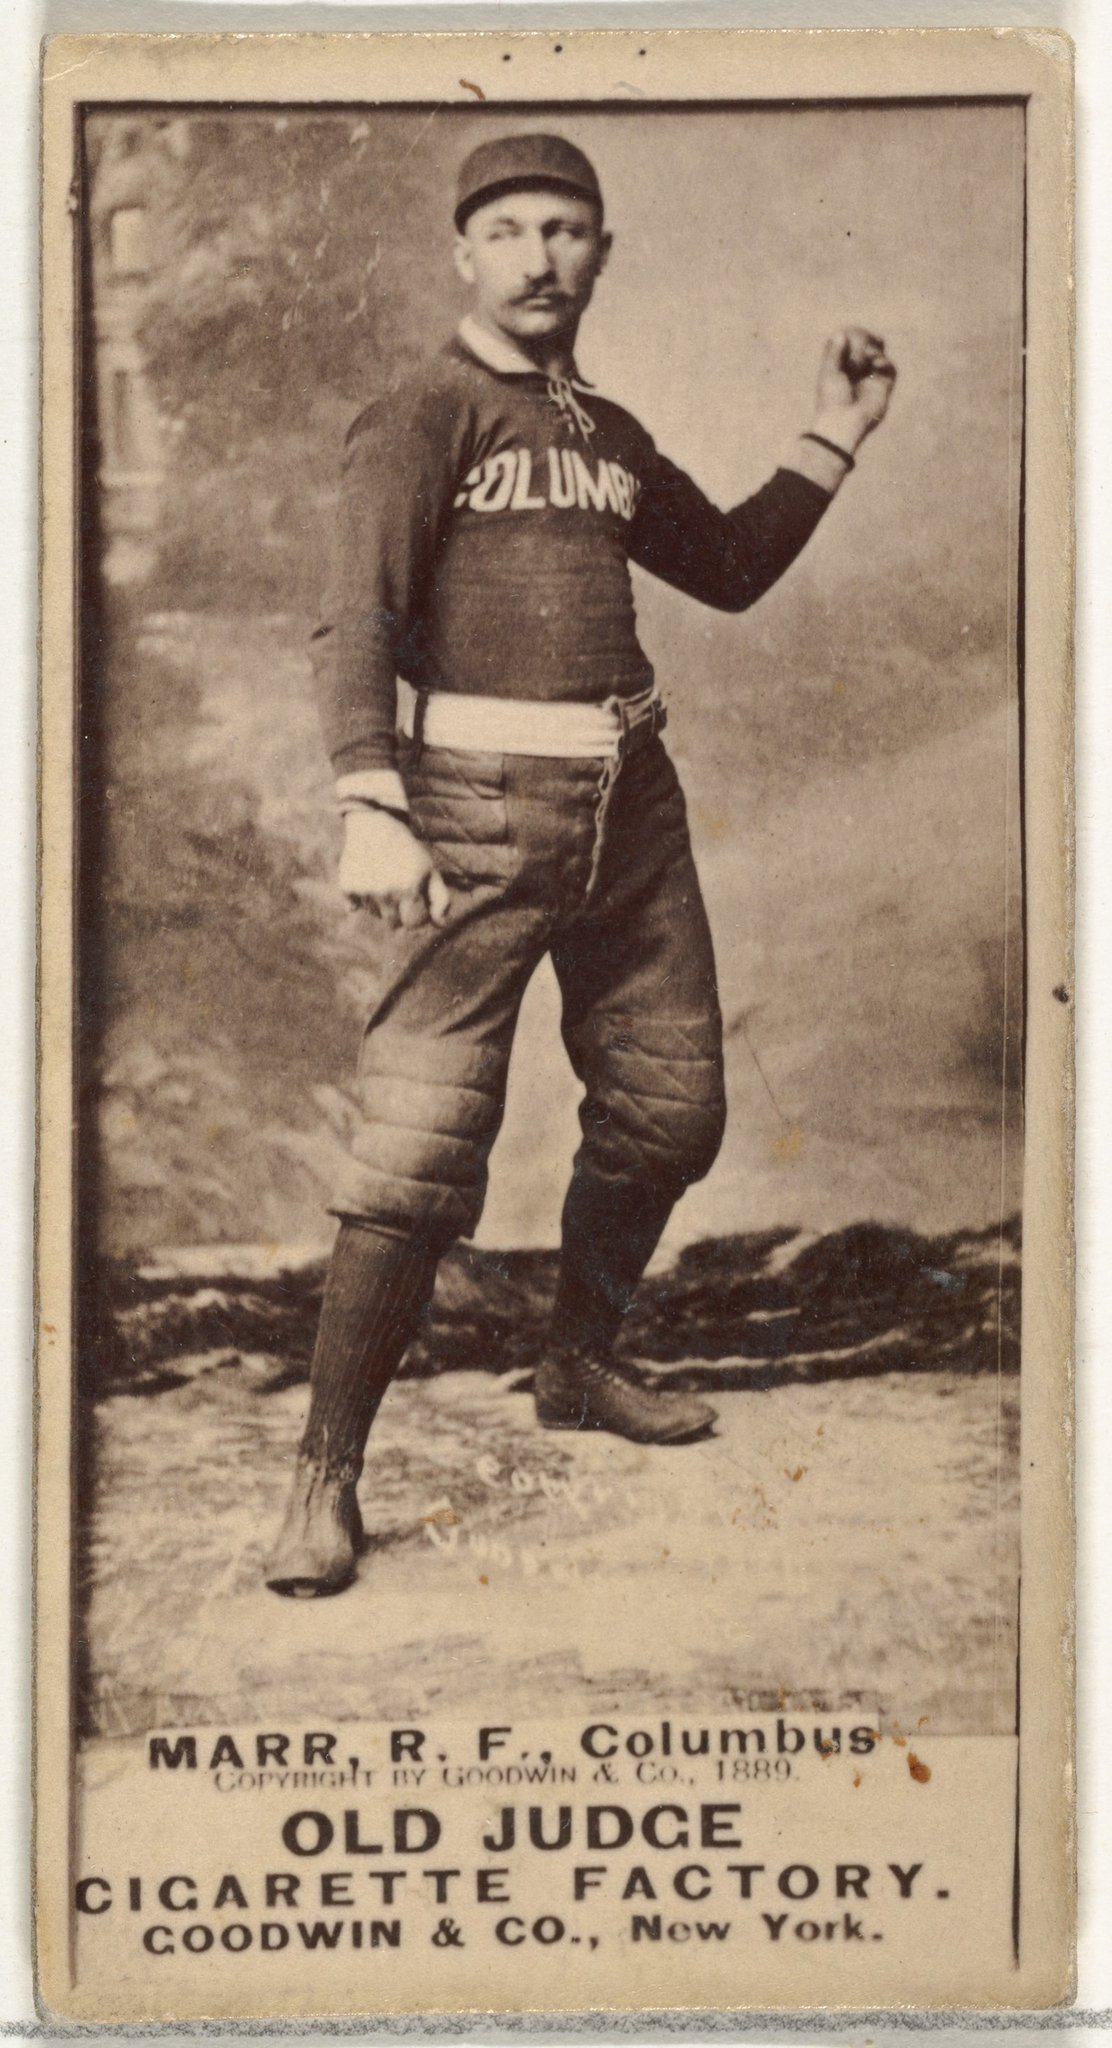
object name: baseball card, photograph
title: Charles W. "Lefty" Marr, Right Field, Cleveland, from the Old Judge series (N172) for Old Judge Cigarettes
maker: goodwin & company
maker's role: publisher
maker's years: 1850-1950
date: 1889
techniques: albumen silver print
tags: men,portraits,baseball,athletes